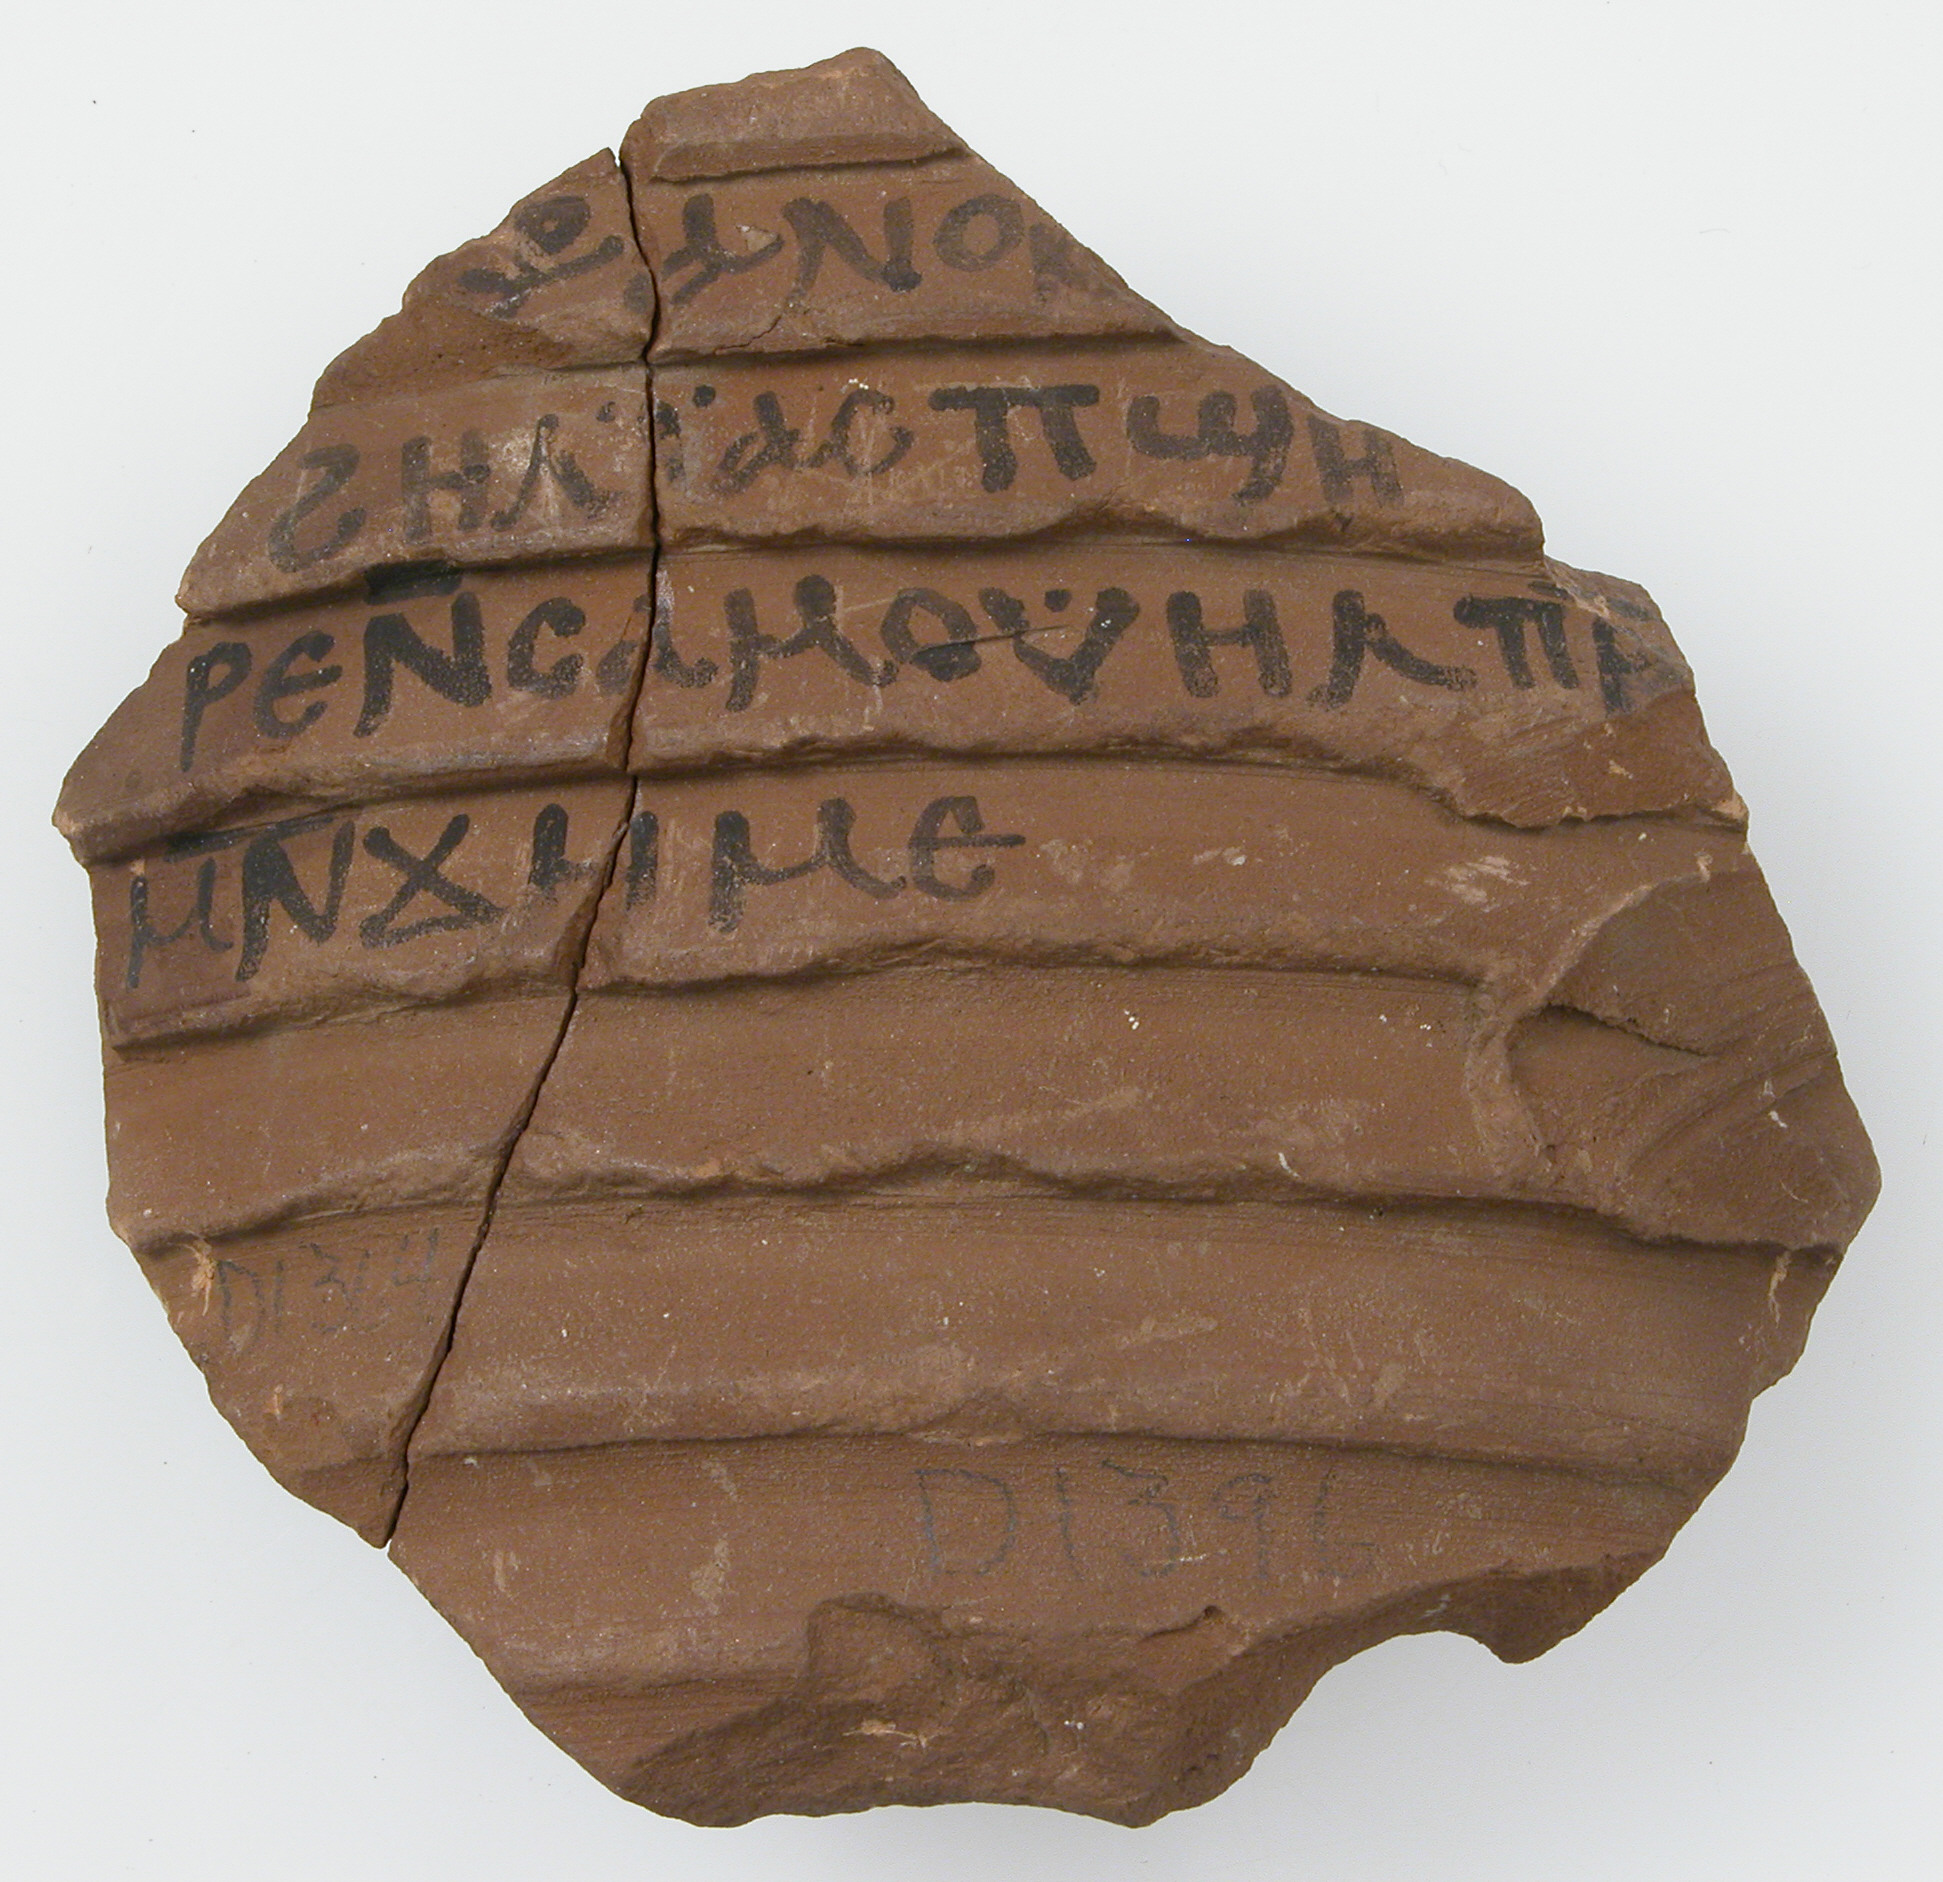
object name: ostrakon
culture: coptic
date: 601-700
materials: ink, pottery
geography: egypt